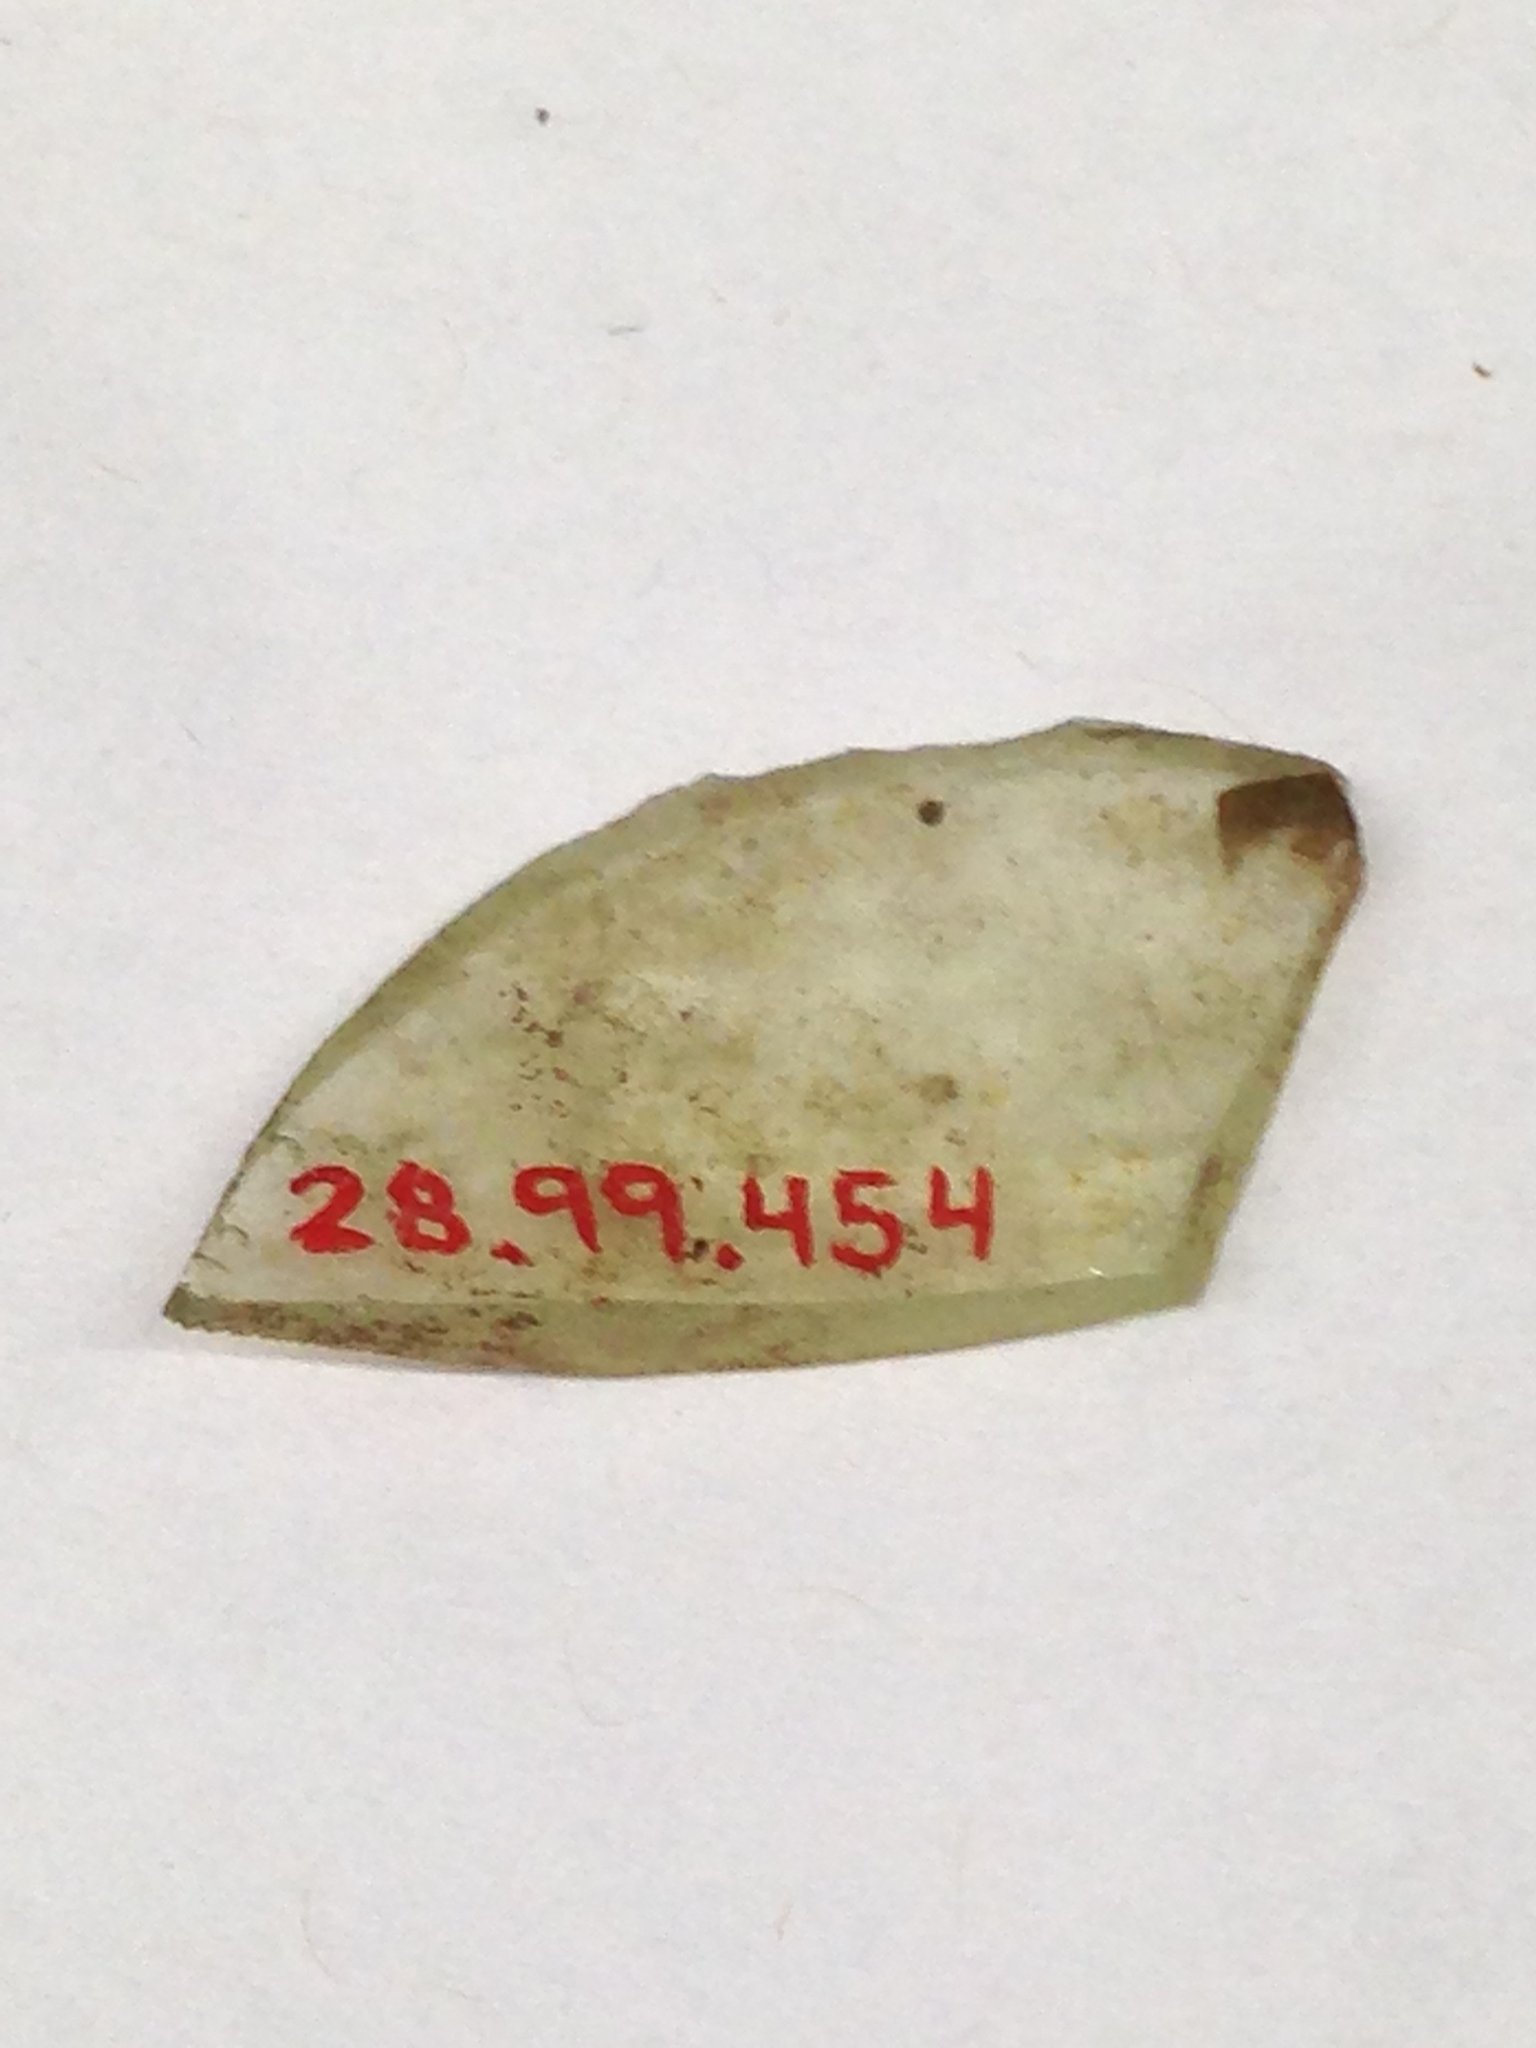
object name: fragment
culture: european or middle eastern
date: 1150-1250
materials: ceramic, glass